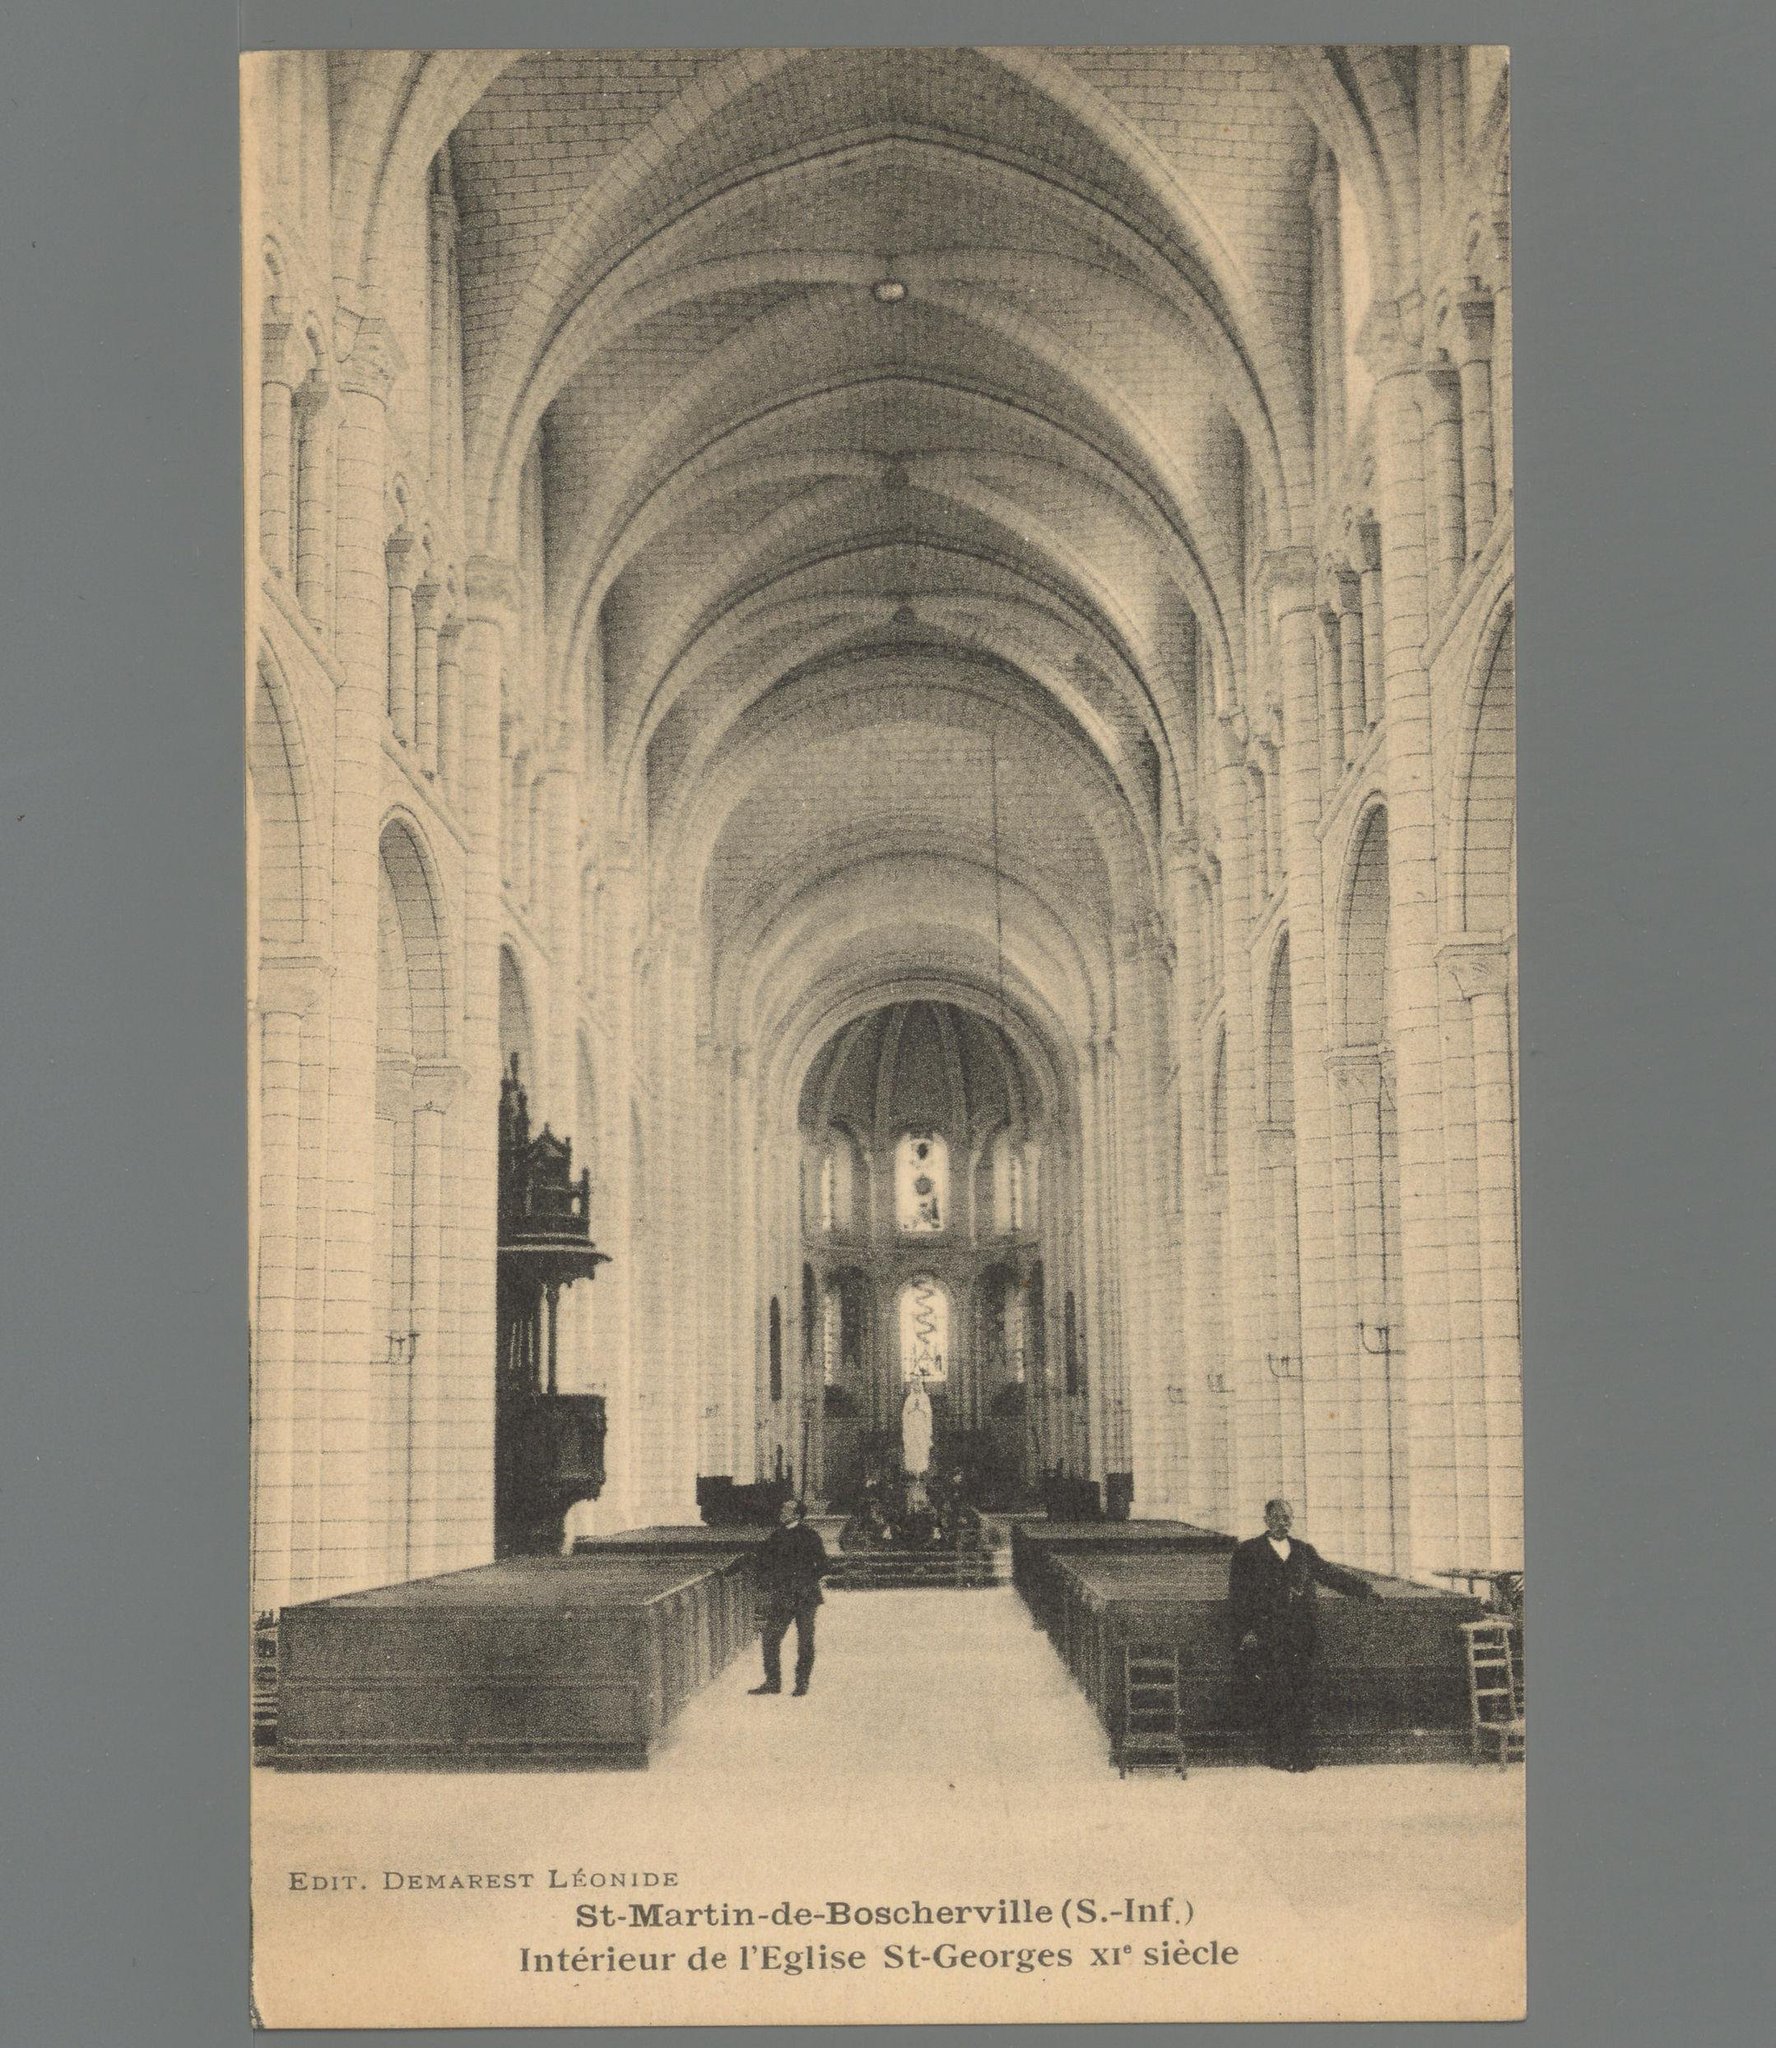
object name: ansichtkaart, prentbriefkaart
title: St.-Martin-de-Boscherville (S.-Inf). Intérieur de l'Eglise St. Georges, XIe siècle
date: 1903-1920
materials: cardboard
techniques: photograph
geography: saint-martin-de-boscherville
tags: interior of church